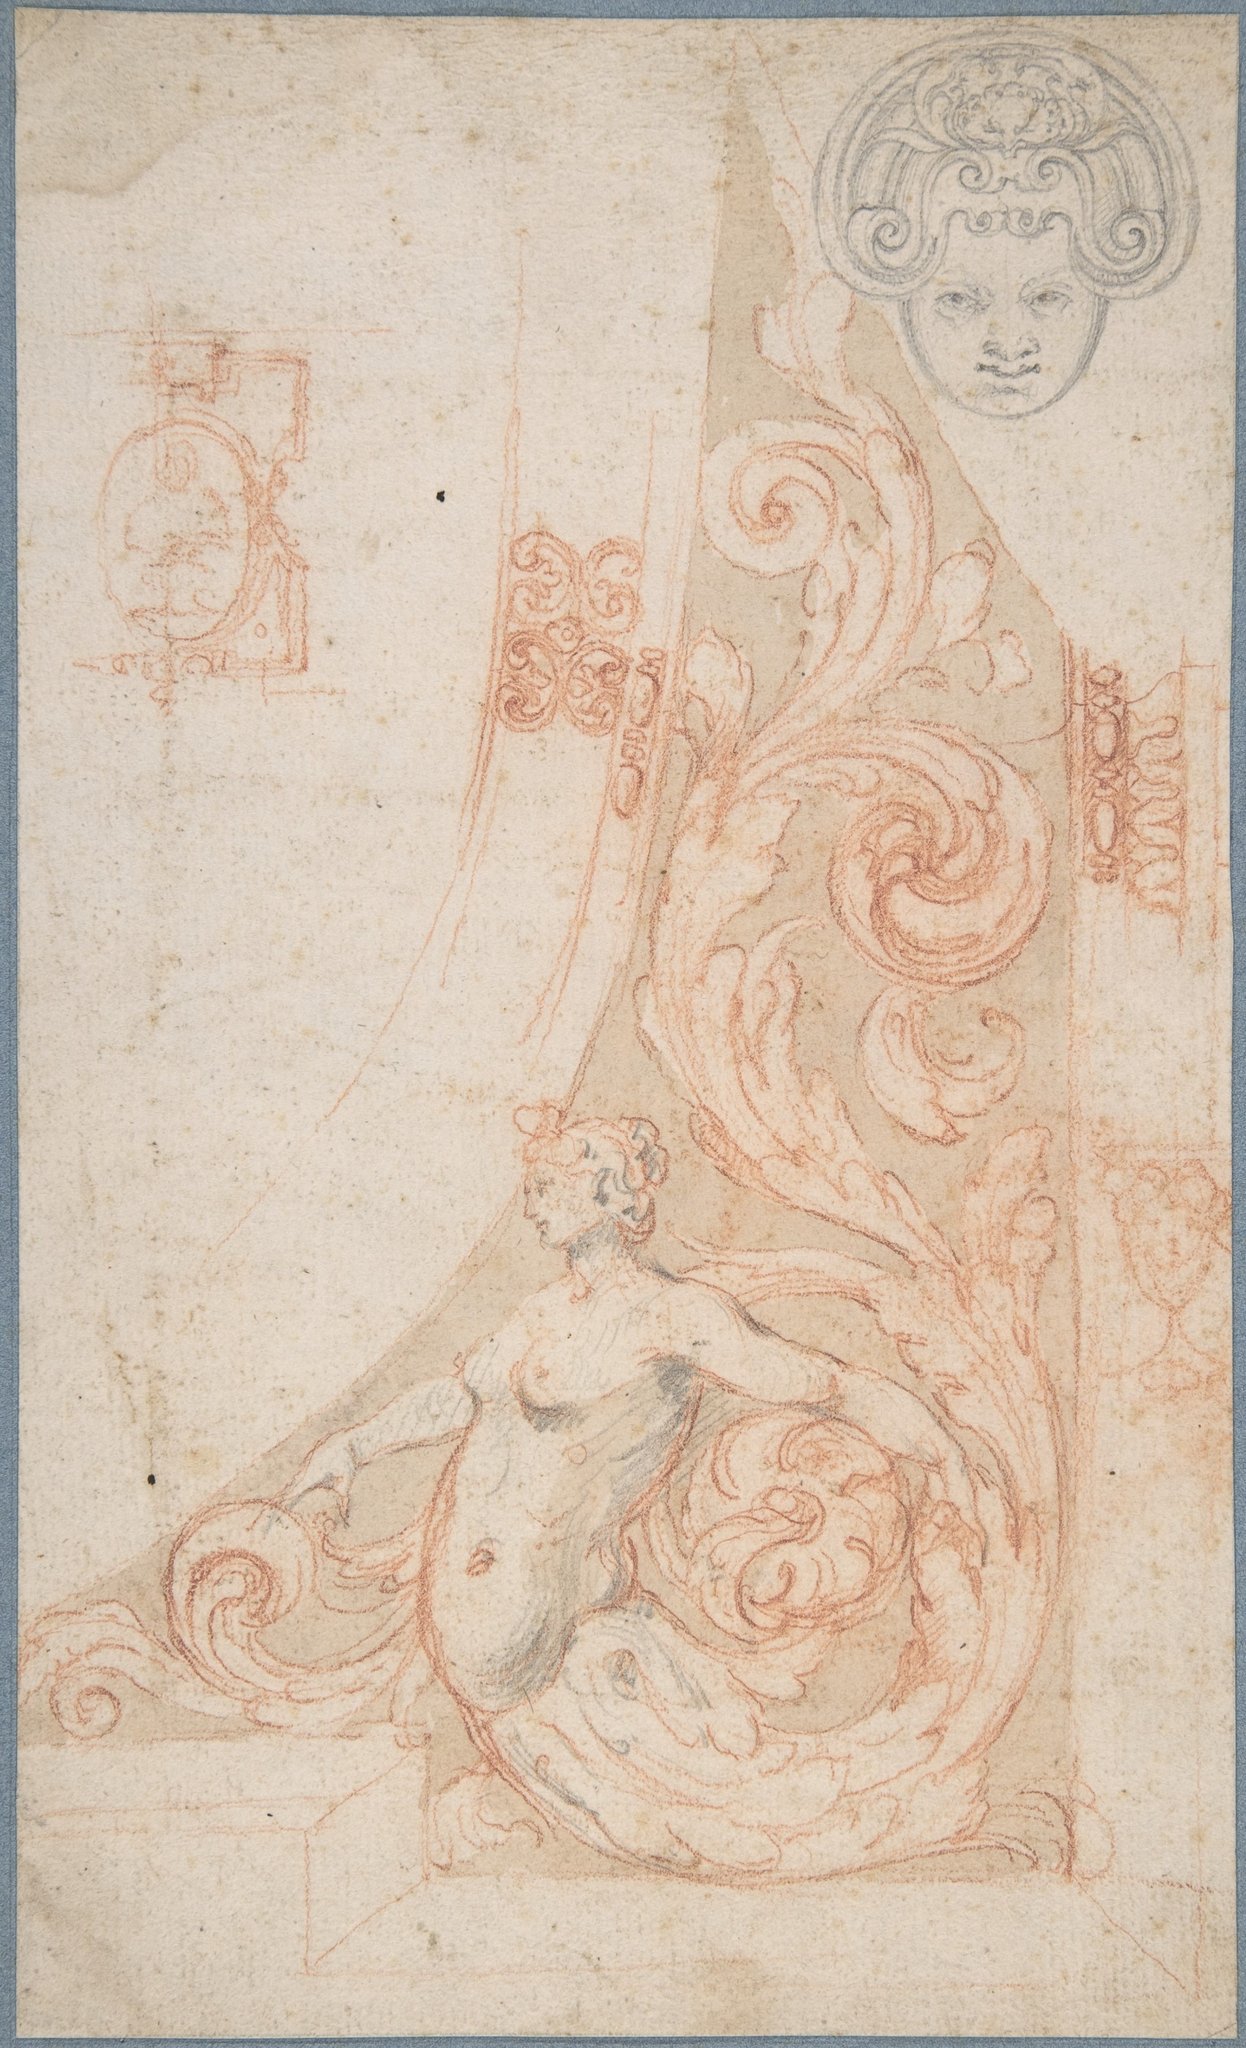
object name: drawing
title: Frame Design with Antique Design, and other sketches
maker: anonymous, italian, 17th century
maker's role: artist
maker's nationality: italian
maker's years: 1600-1700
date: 1601-1700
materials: chalk, graphite